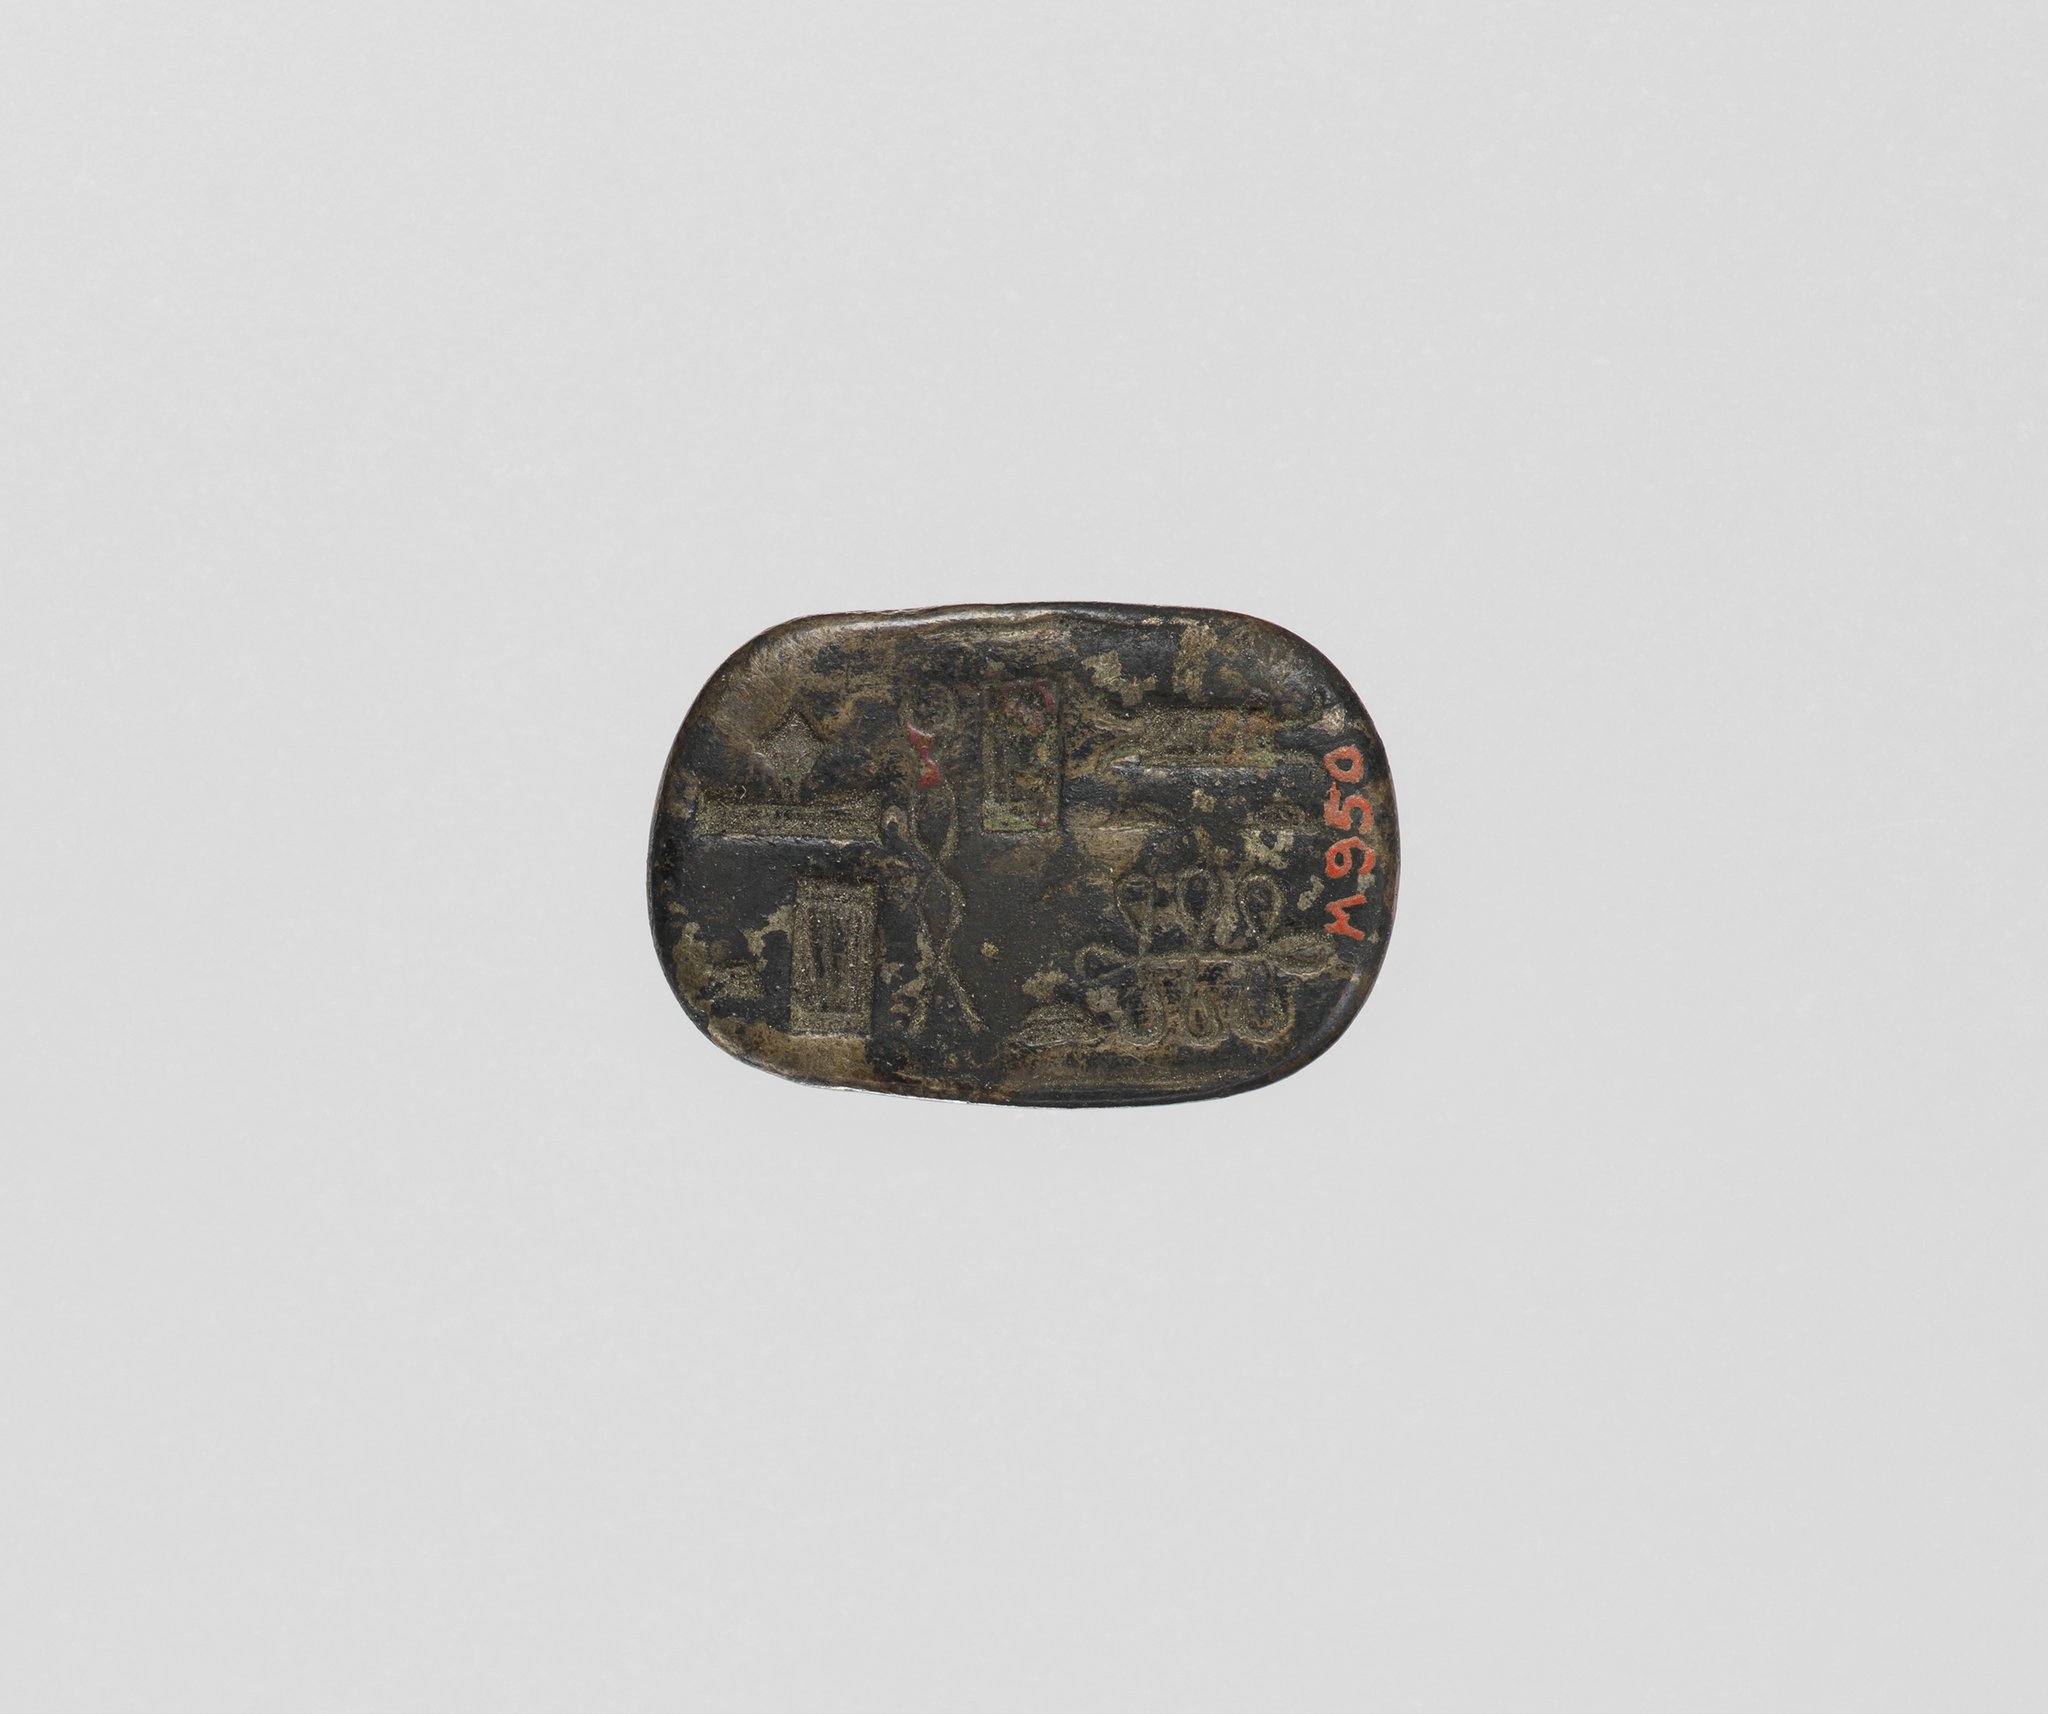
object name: ring bezel, ptahhotep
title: Ring bezel of Ptahhotep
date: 664-525 BCE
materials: bronze, copper alloy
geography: egypt